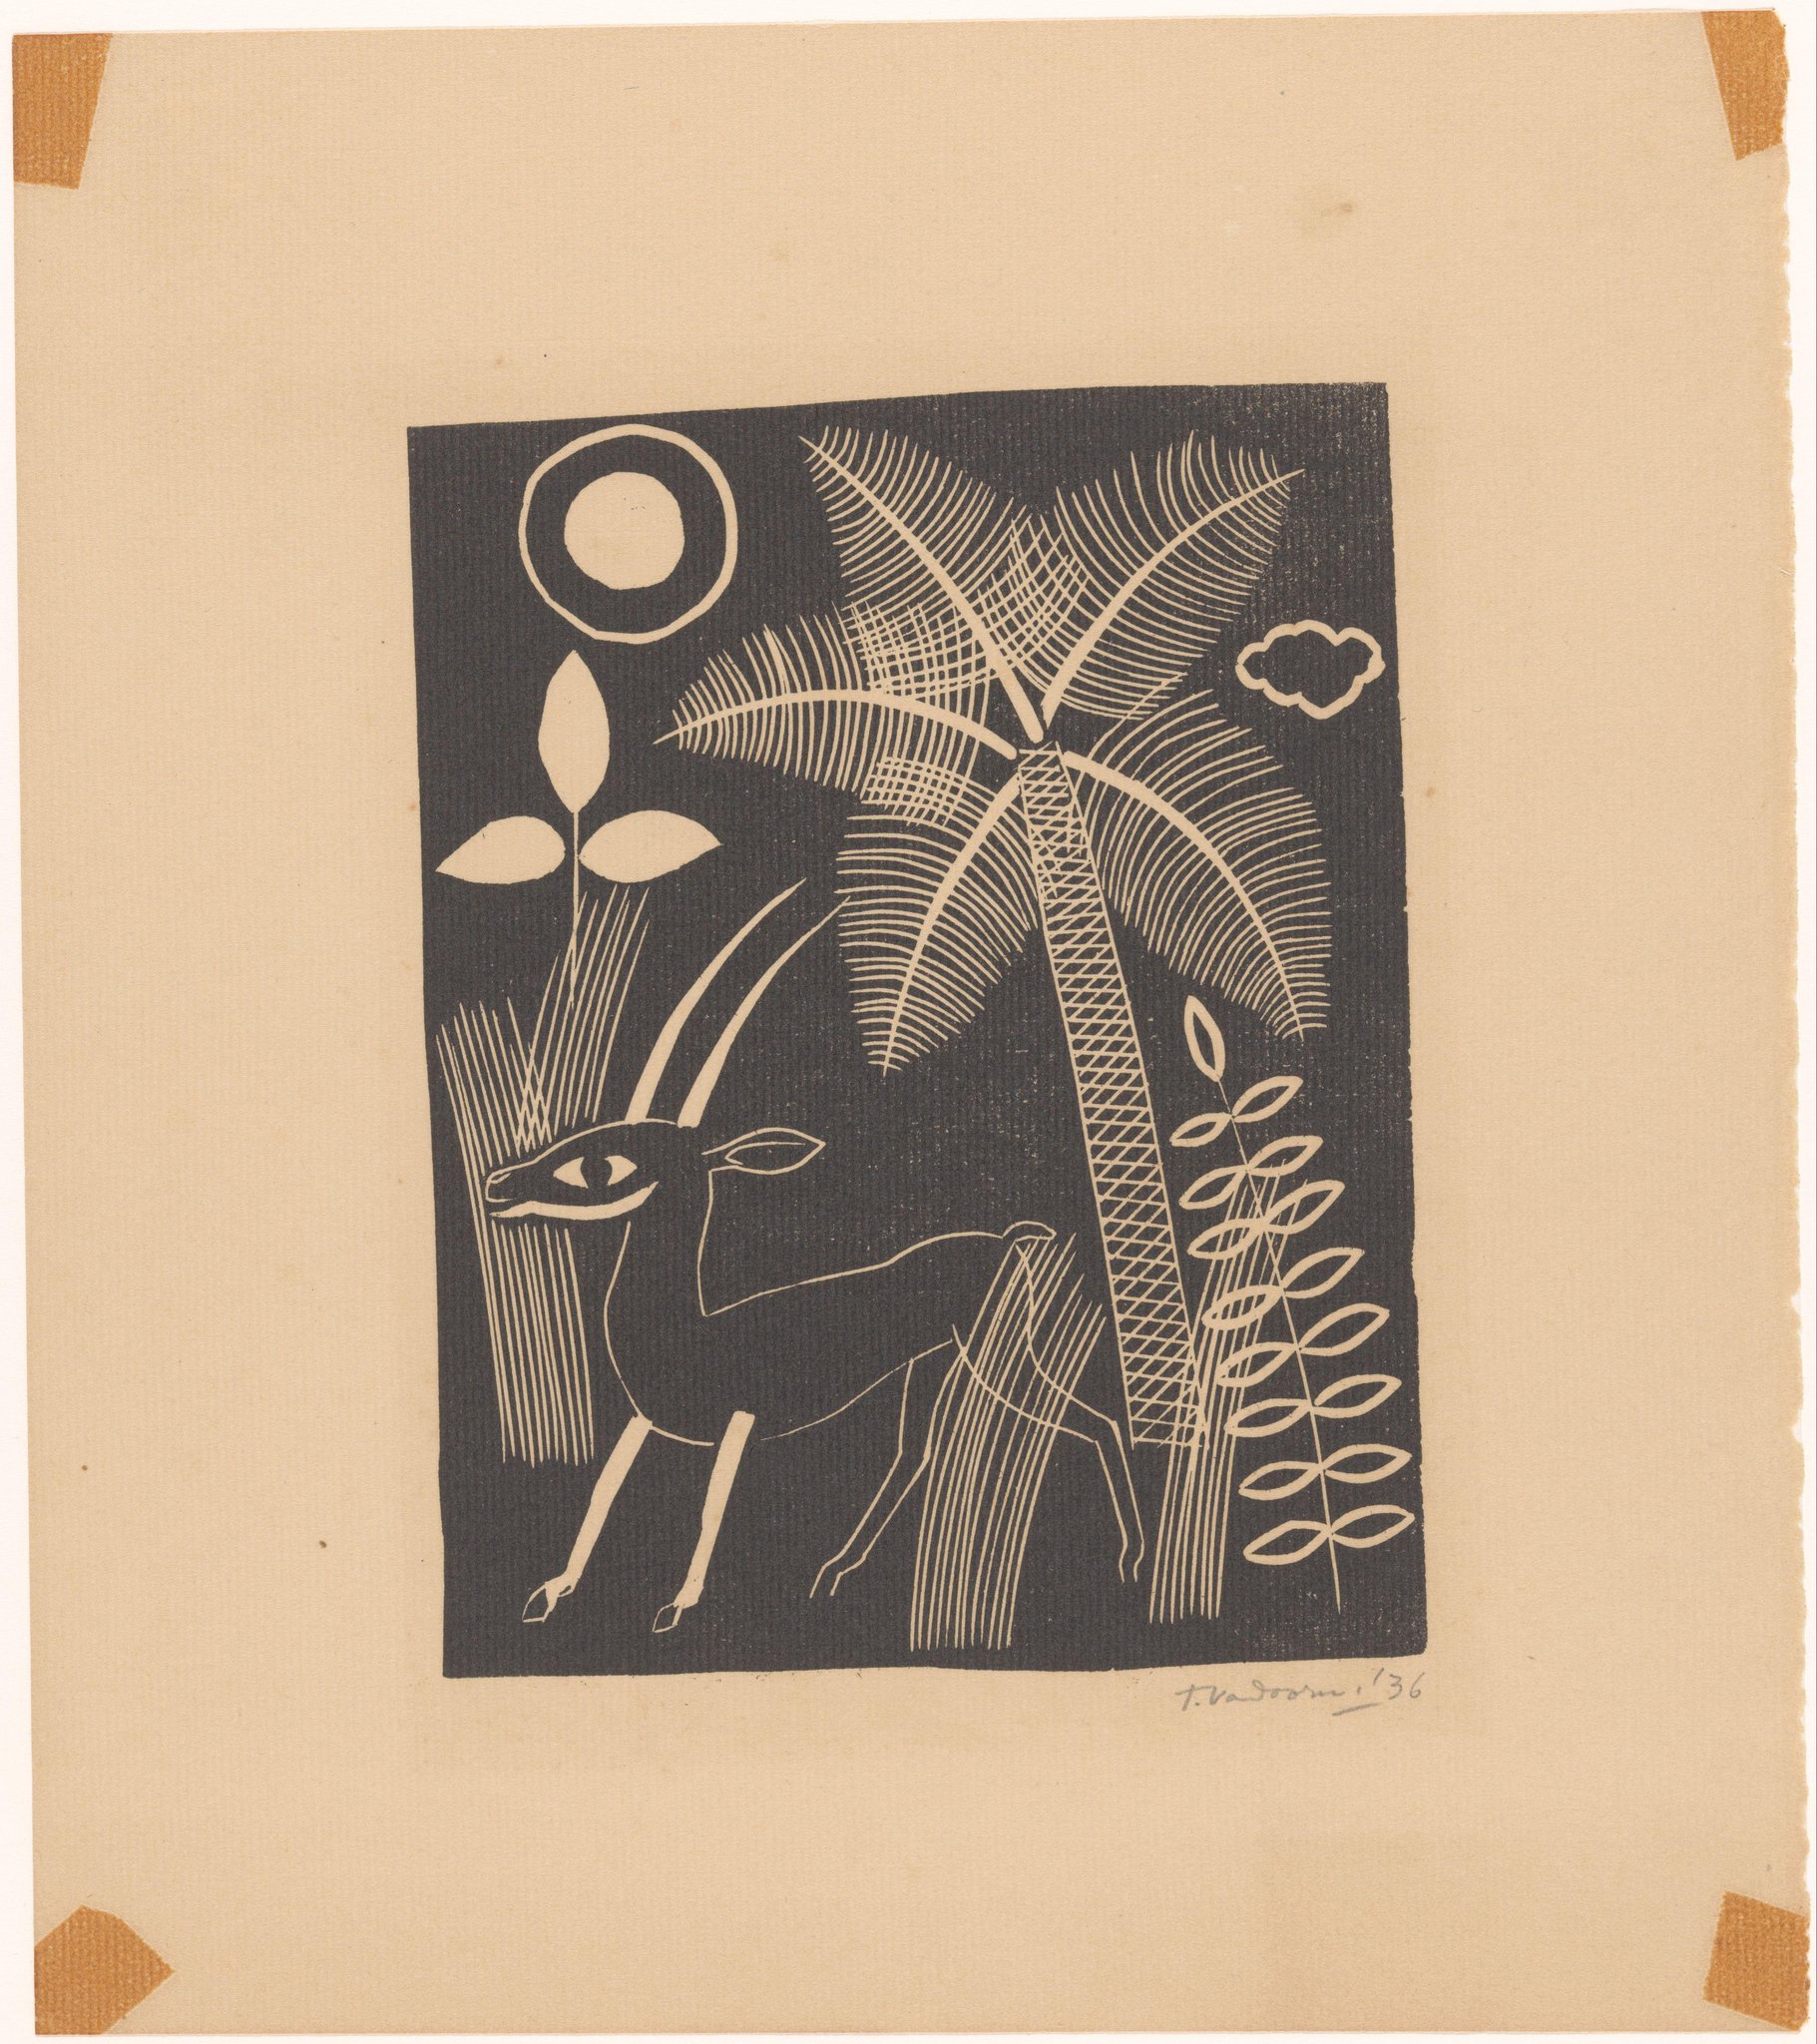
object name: print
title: Hert met palmboom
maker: tinus van doorn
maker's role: painter, print maker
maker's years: 1905-1940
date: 1936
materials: ink, paper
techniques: linocut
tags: hoofed animals: deer, trees: palm-tree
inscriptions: signature and date: ‘T.vanDoorn. '36’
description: Compositie met een hertachtig dier, een palmboom, gras, bladeren en een wolk. Linksboven is een volle maan of een zon te zien.